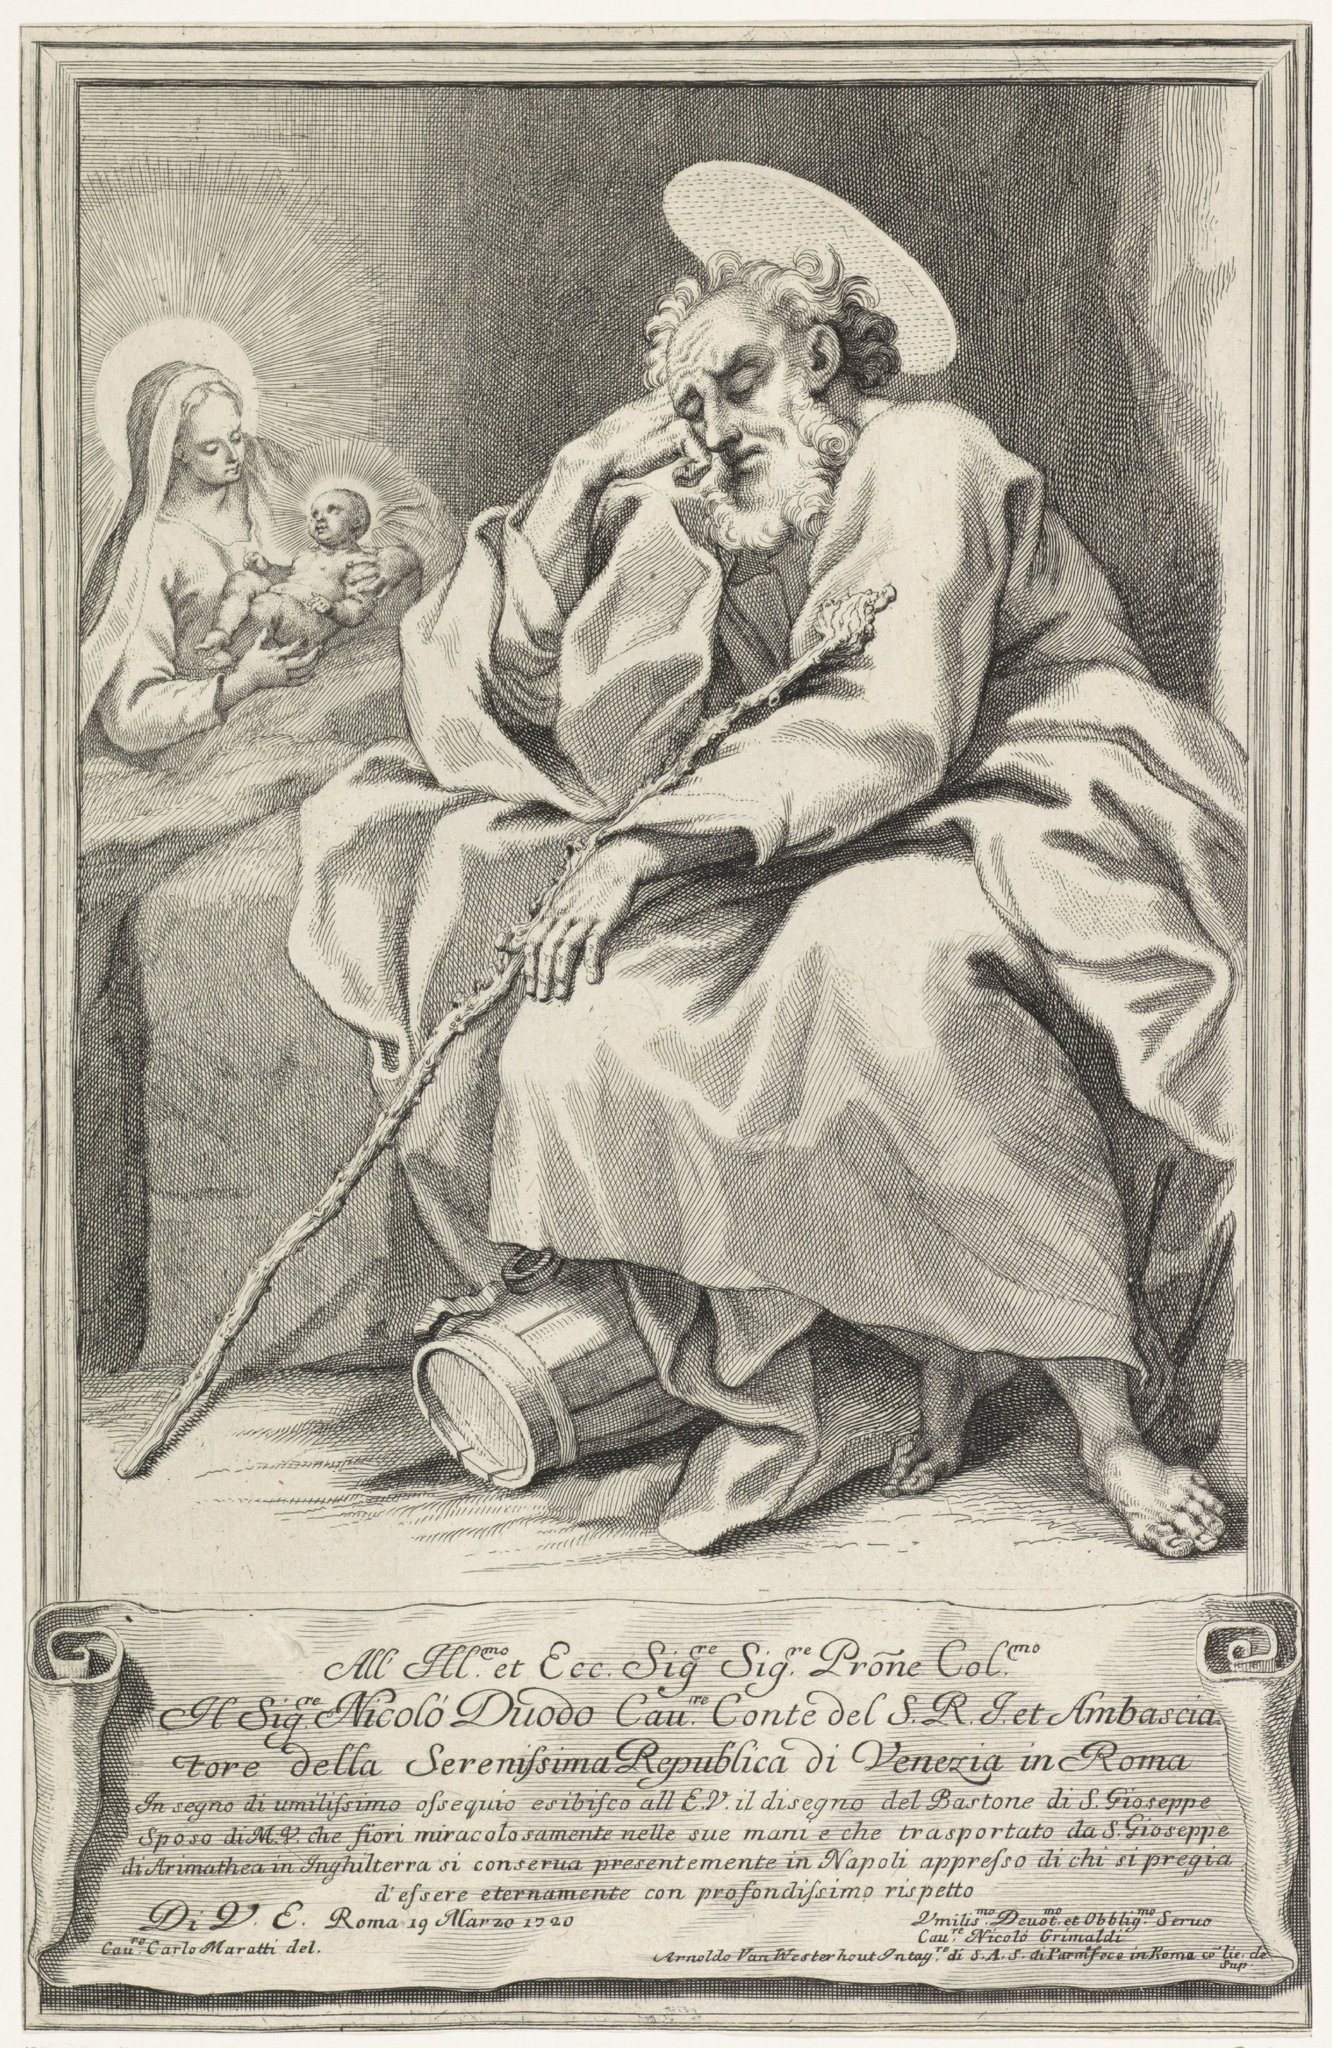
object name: print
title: Slapende Jozef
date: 1720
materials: paper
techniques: engraving, etching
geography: venice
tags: madonna: i.e. mary with the christ-child, the foster-father of christ, joseph of nazareth, husband of mary; possible attributes: flowering rod or wand, lily, carpenter's tools, sleeping; unconsciousness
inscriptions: collector's mark: Lugt 2228, inscription:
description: Jozef slaapt, leunend op zijn arm. In zijn hand een wandelstok. Op de achtergrond Maria met het Christuskind in haar armen. Onder de voorstelling een zevenregelig onderschrift met een opdracht in het Latijn.